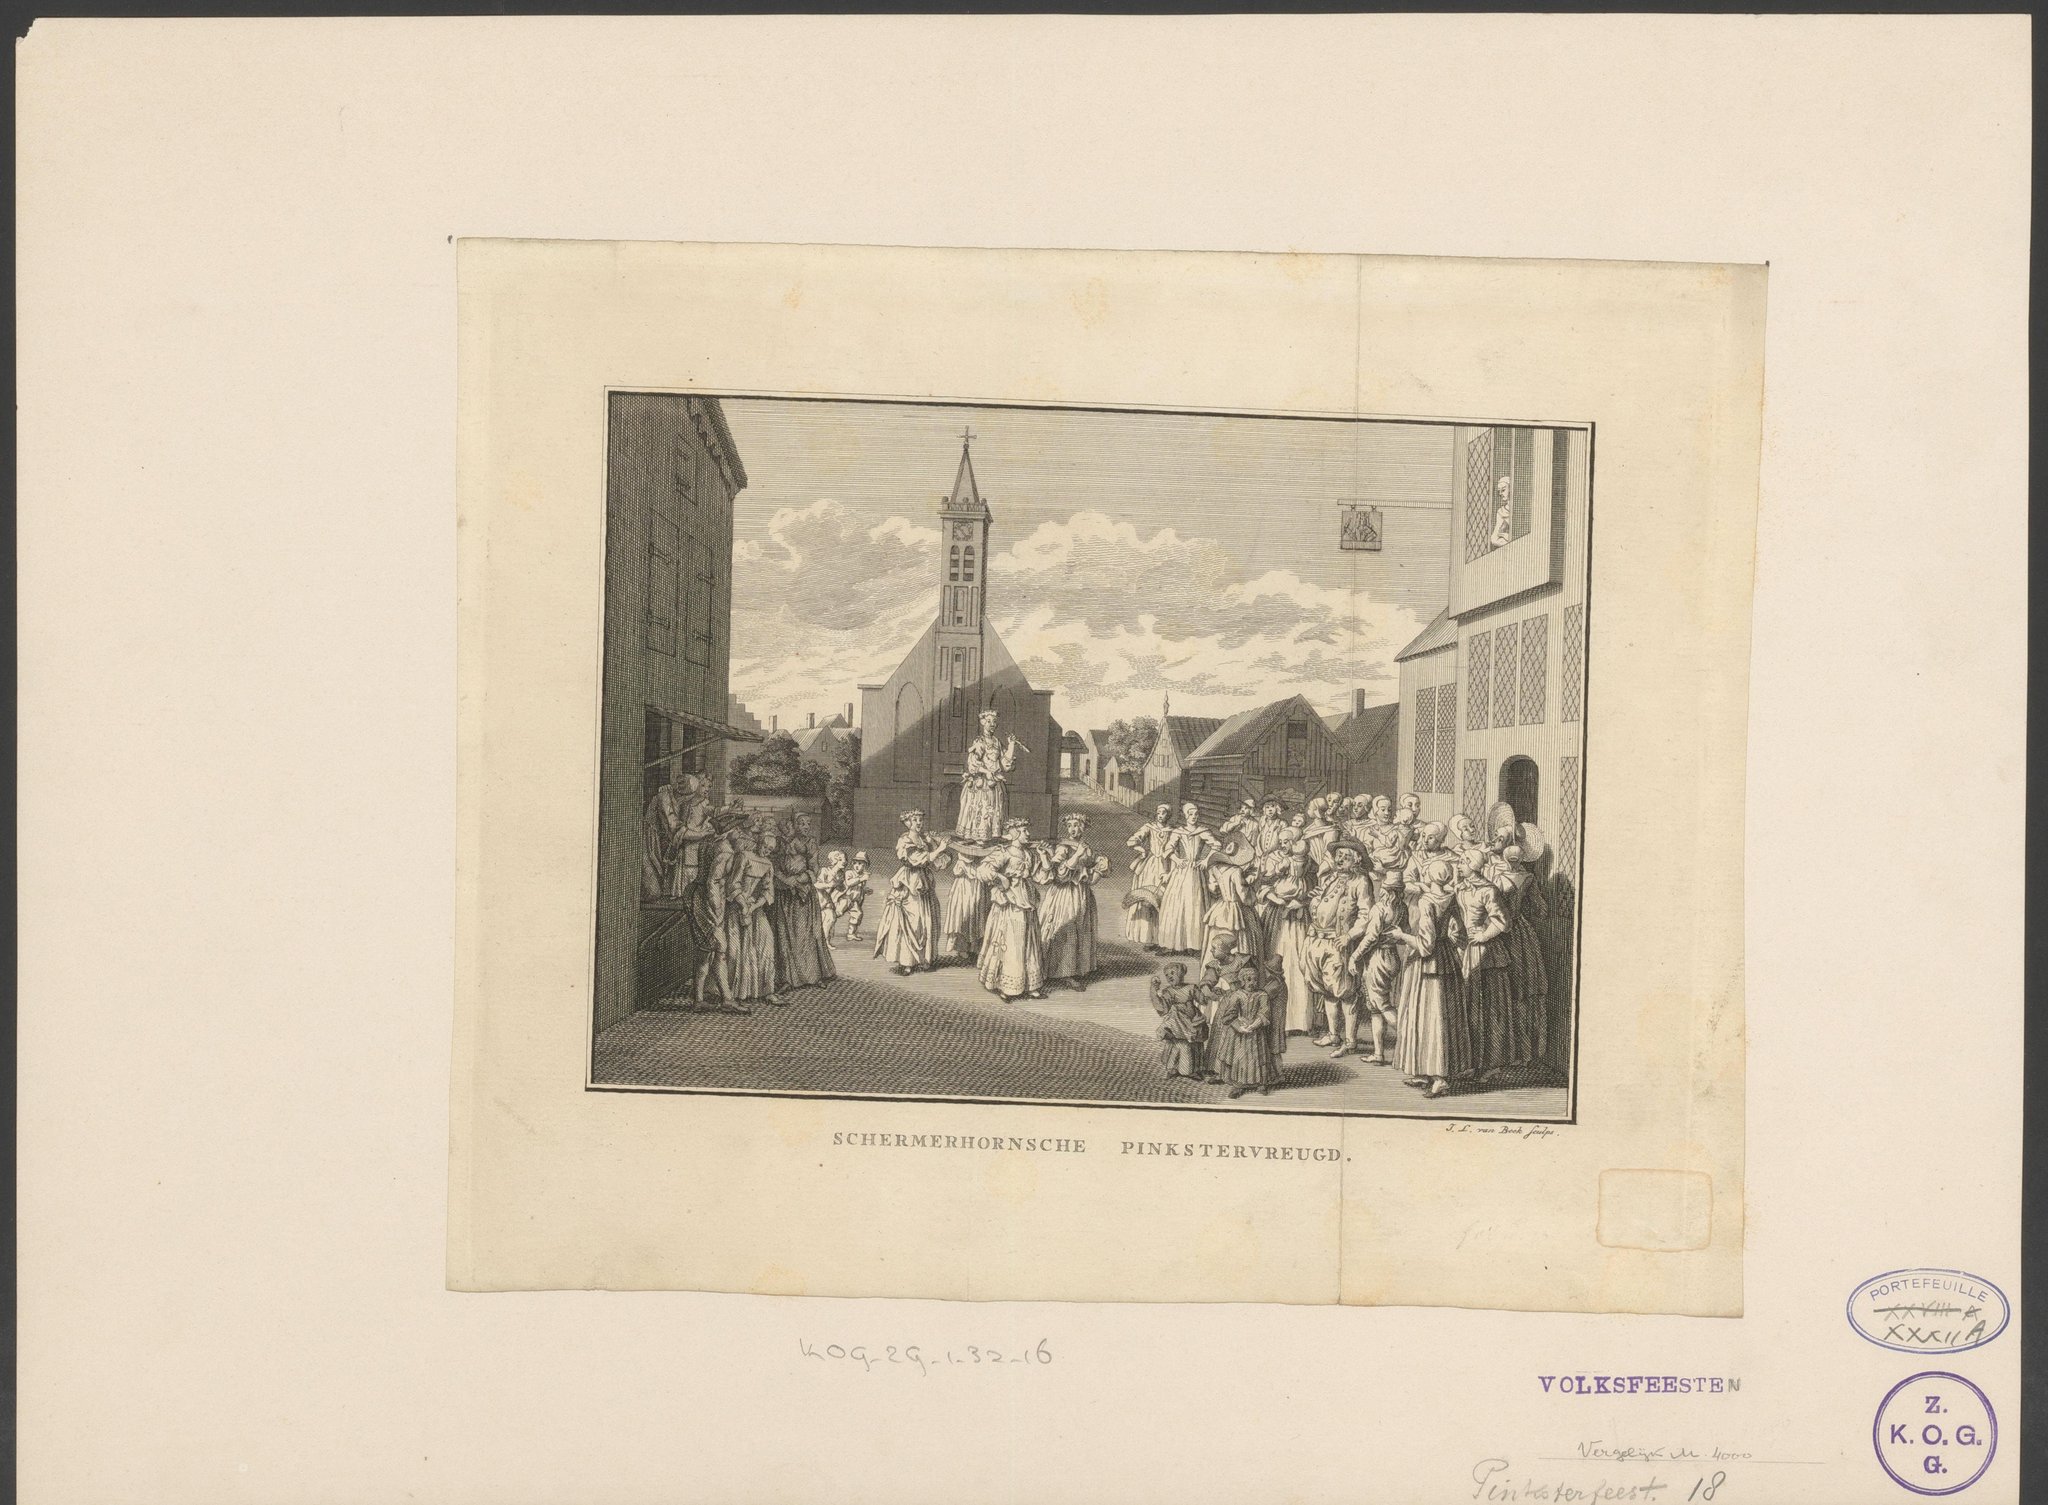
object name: print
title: Meisje met fluit (Pinksterblom) op baar gedragen door vier meisjes tijdens Pinksterfeest in Schermerhorn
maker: jan lucas van der beek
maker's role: draughtsman, print maker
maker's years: 1753-1818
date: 1763-1818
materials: paper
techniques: engraving, etching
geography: amsterdam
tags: pentecost, whitsunday, calendar festivals, non-liturgical celebrations of days belonging to the ecclesiastical calendar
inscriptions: collector's mark: Lugt 1641, collector's mark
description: Meisje met fluit (Pinksterblom) op baar gedragen door vier meisjes tijdens Pinksterfeest in Schermerhorn. Als de toeschouwers in de straten geld werpen dan speelt zij op haar fluit. Op de achtergrond de kerk van Schermerhorn. Onderwerpsrubrieken binnen de Atlas Zeden en Gewoonten: Volksfeesten; Pinksteren.